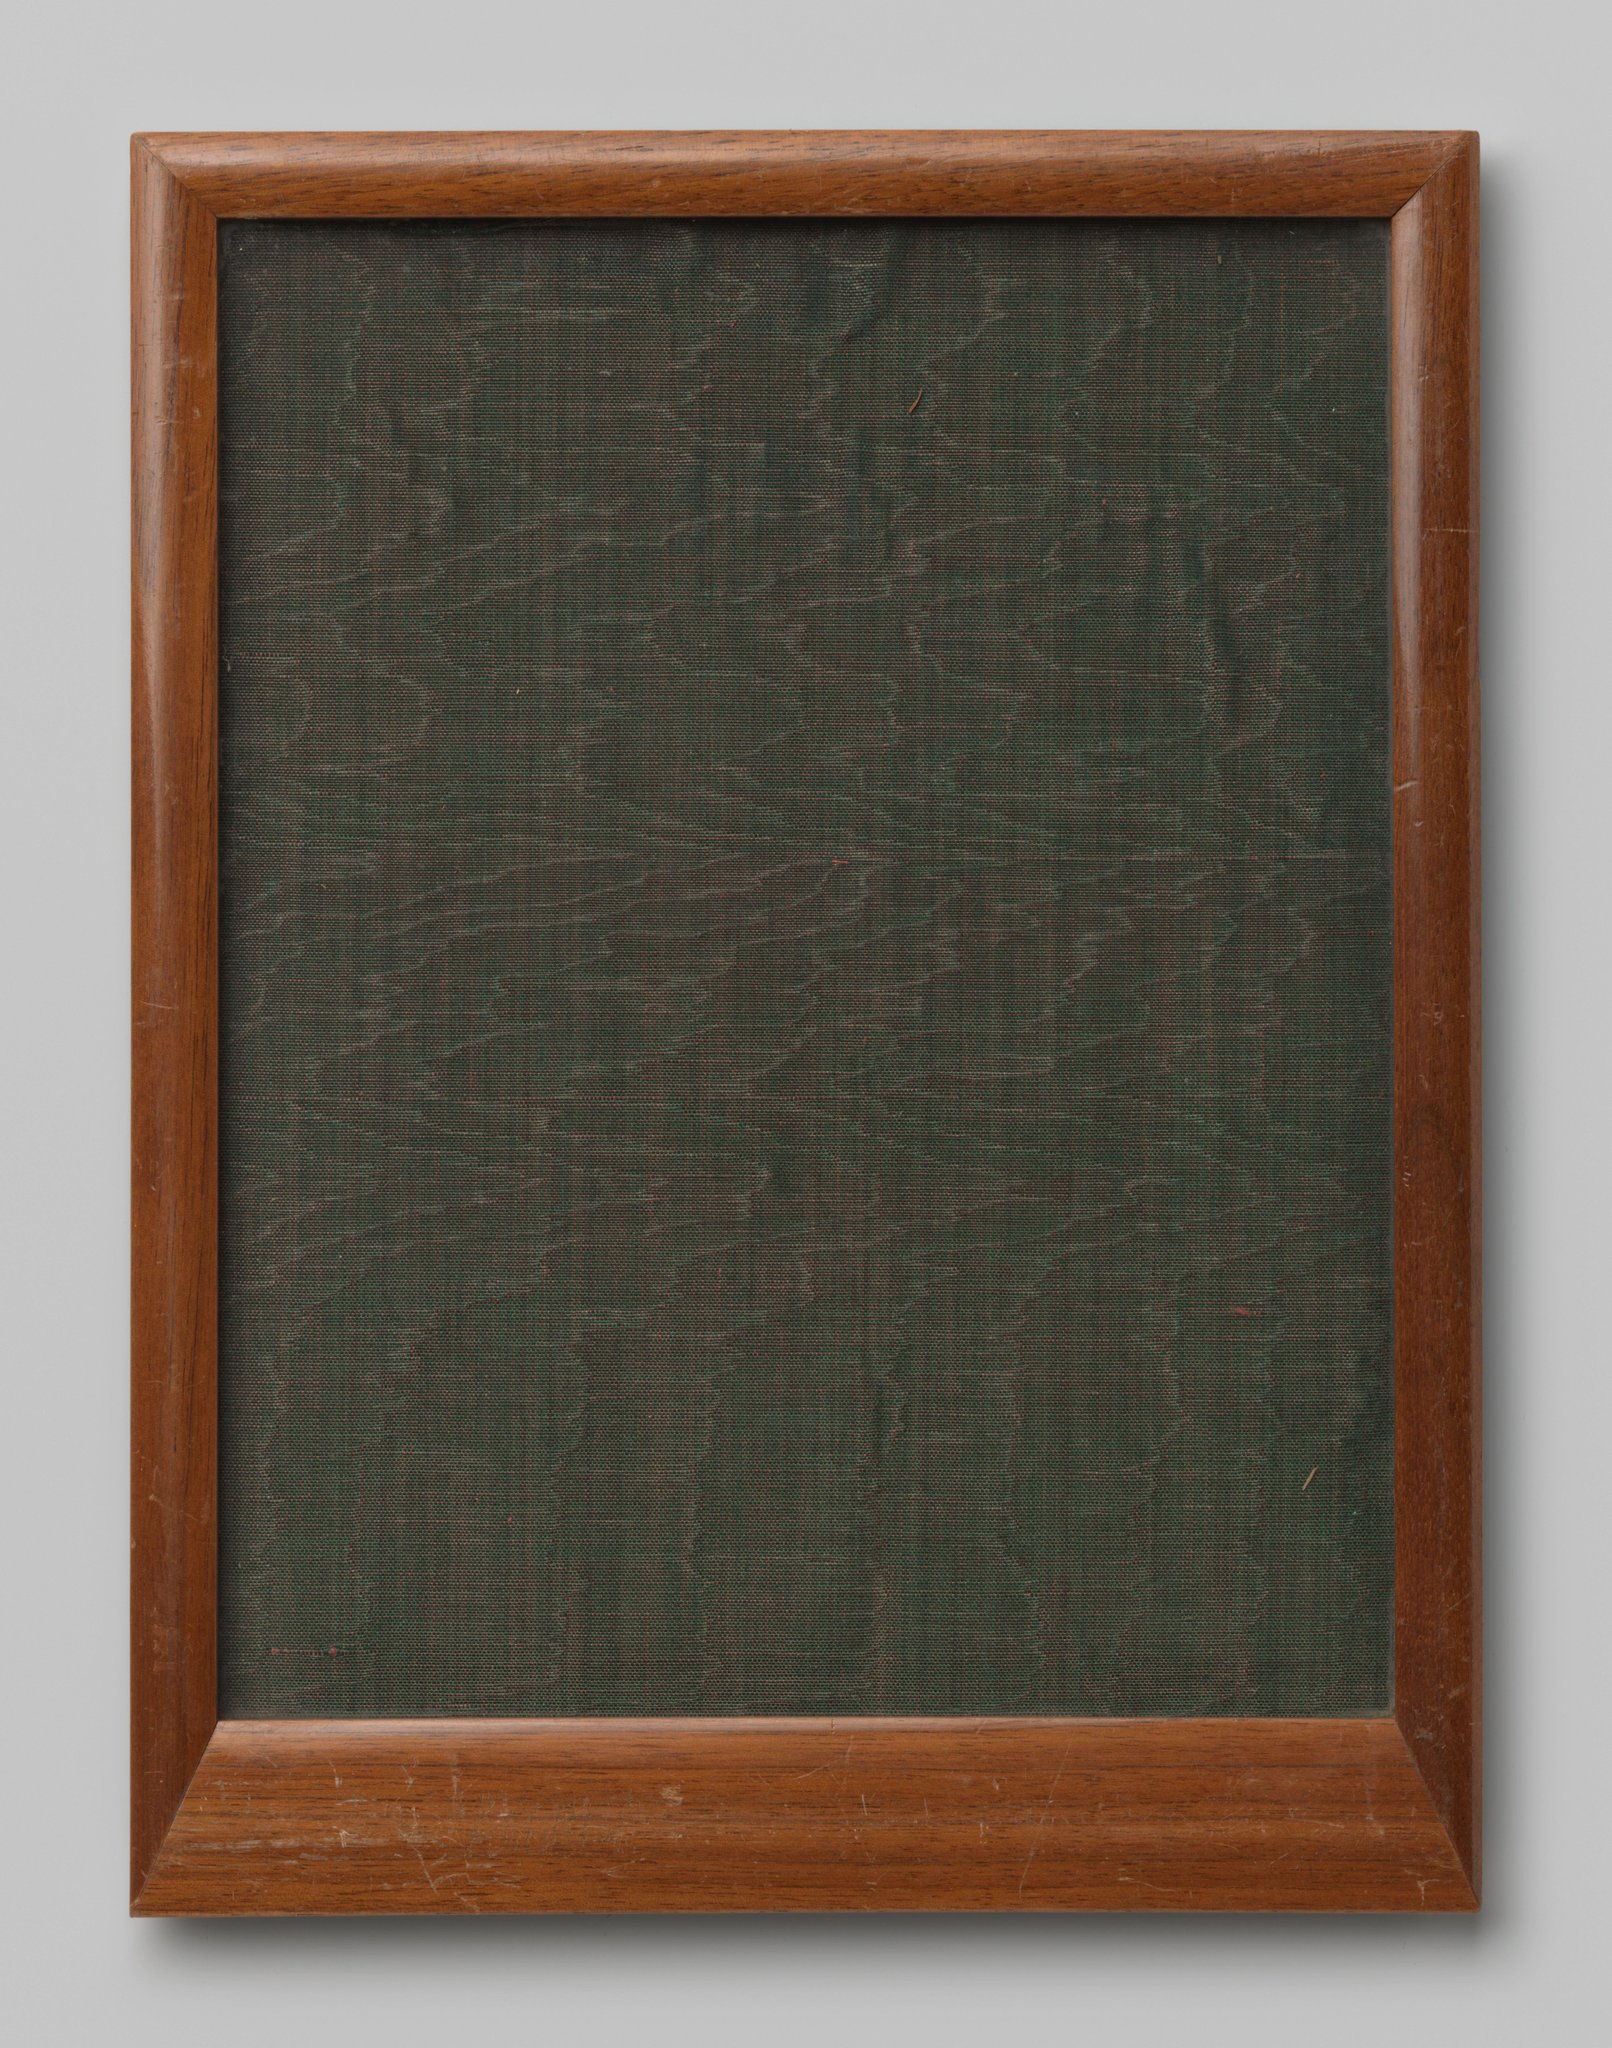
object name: frame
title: Lege lijst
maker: Anonymous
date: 1880-1900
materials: cardboard, glass, textile, wood